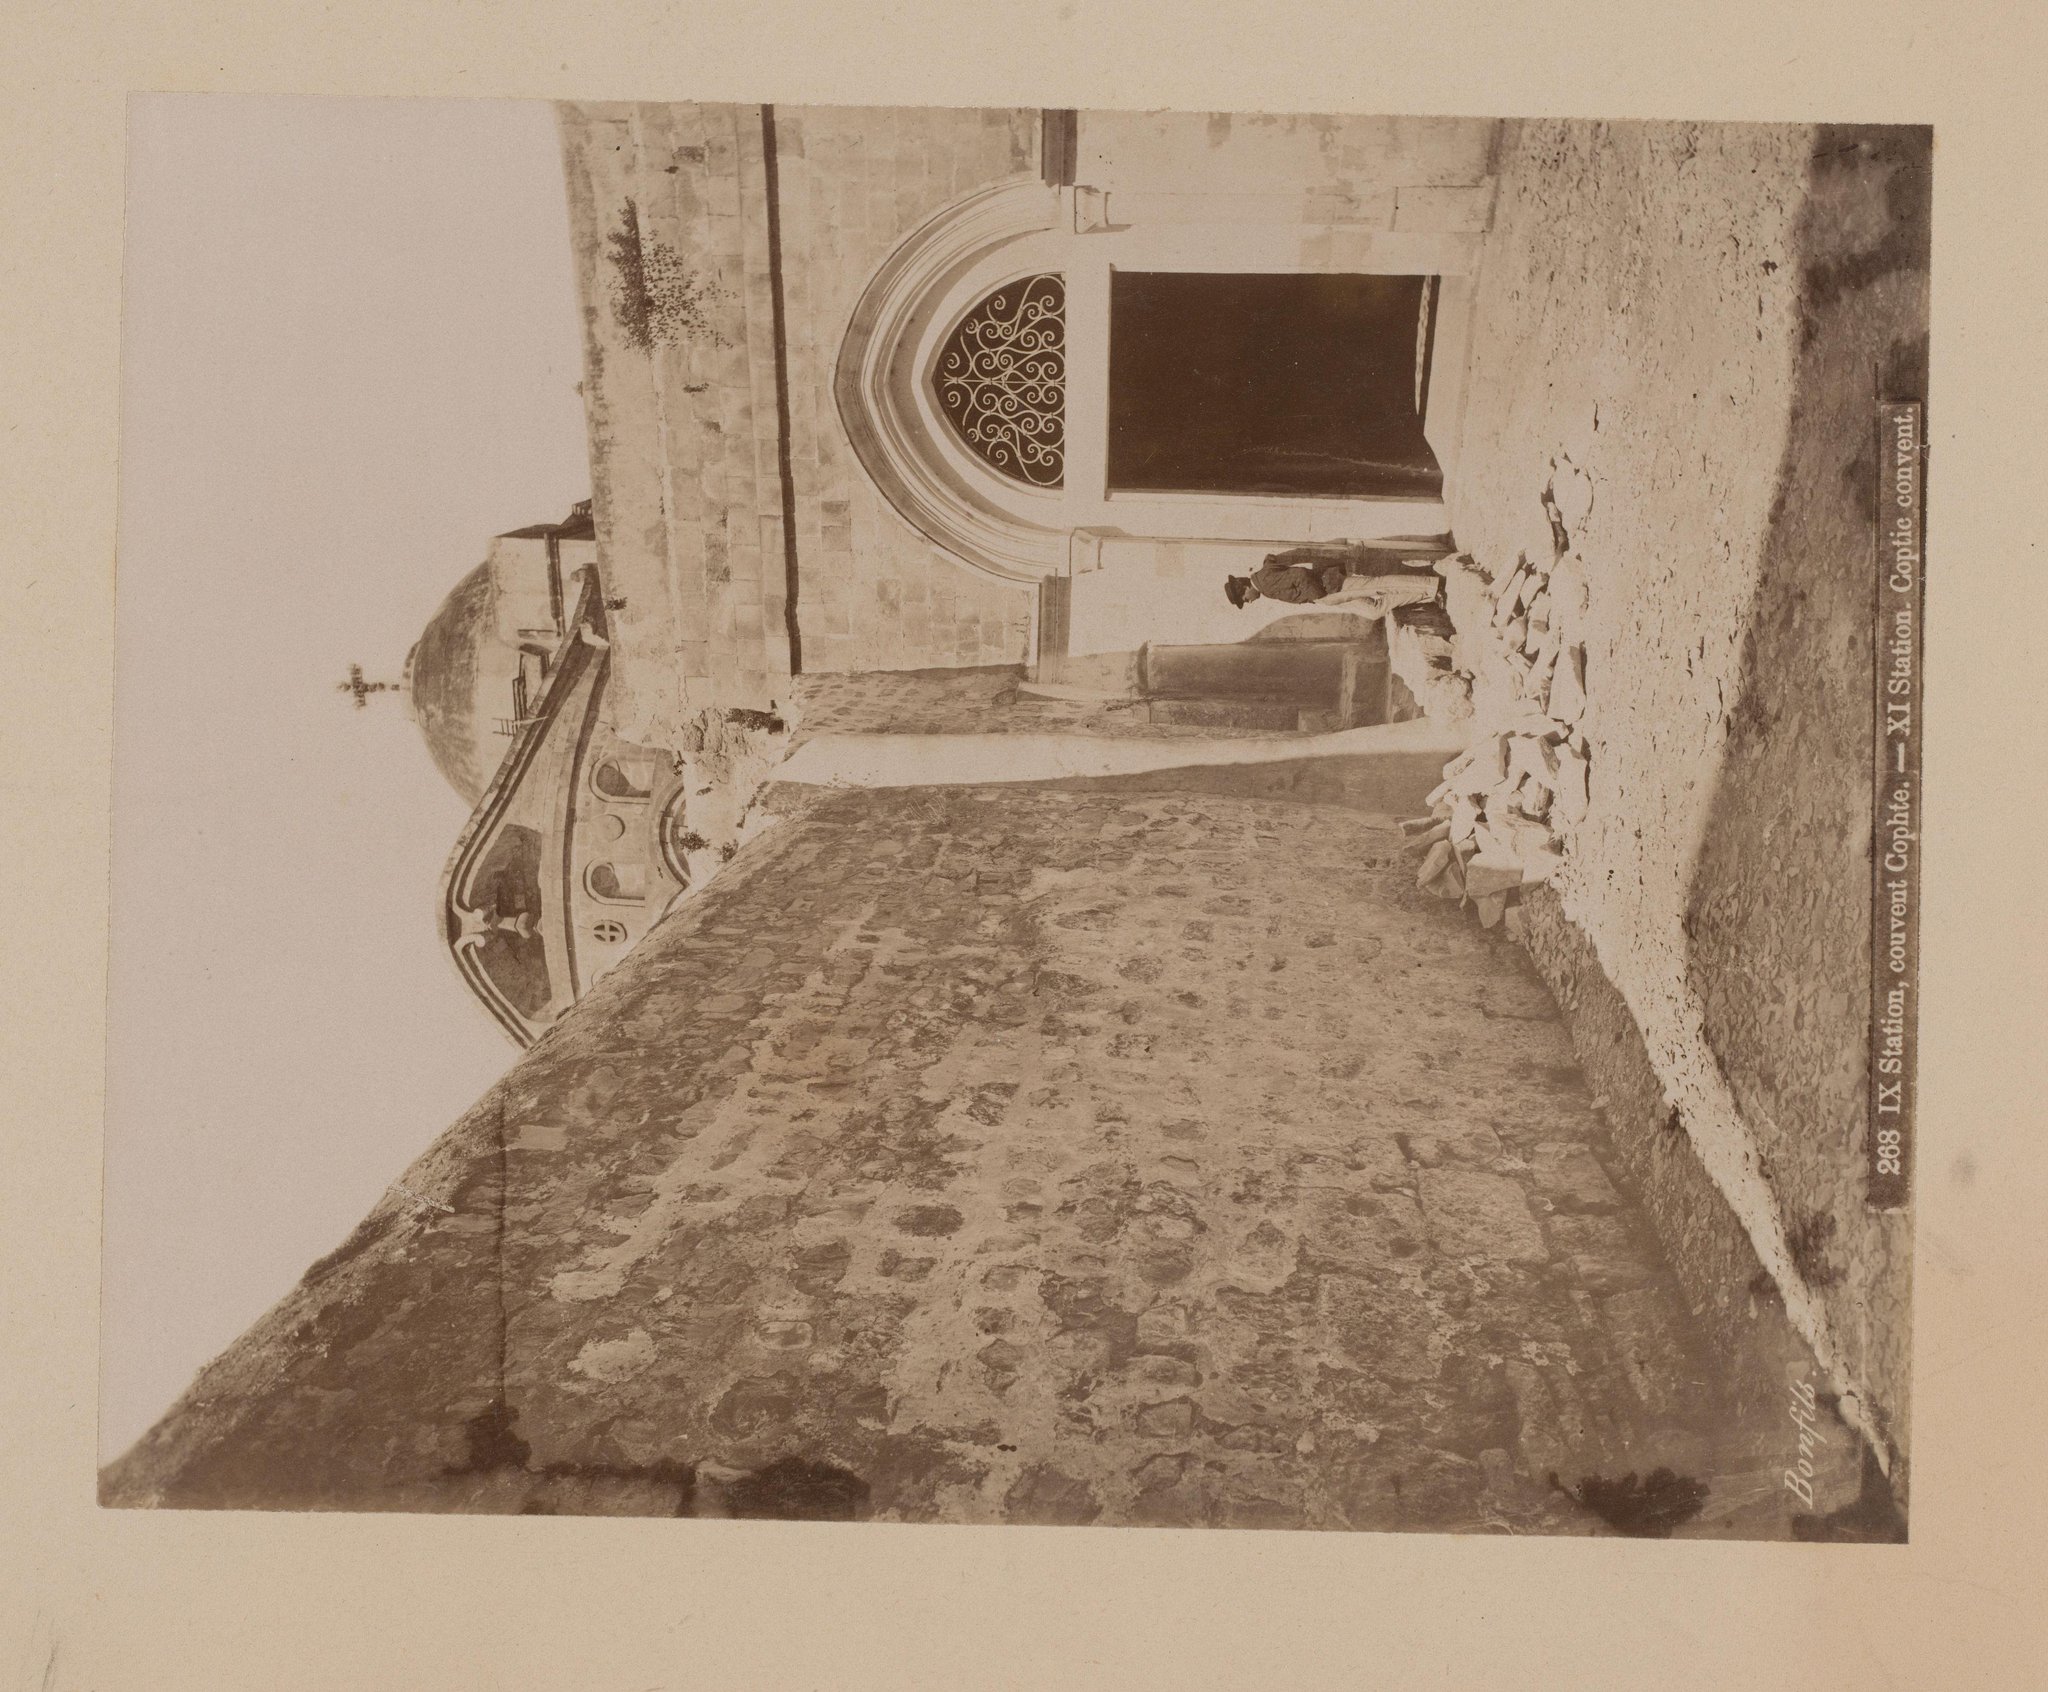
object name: photograph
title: Coptisch klooster, Jeruzalem, Palestina ["268 IX Station, couvent Cophte. - XI Station. Coptic convent"]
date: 1850-1900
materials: cardboard, photographic support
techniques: albumen print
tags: palestina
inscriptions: inscription: ‘Bonfils.’, inscription: ‘268 IX Station, couvent Cophte. - XI Station. Coptic convent.’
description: Op de achtergrond een koepel met een kruis, op de voorgrond staat een man tegen de ingang/deurpost geleund.